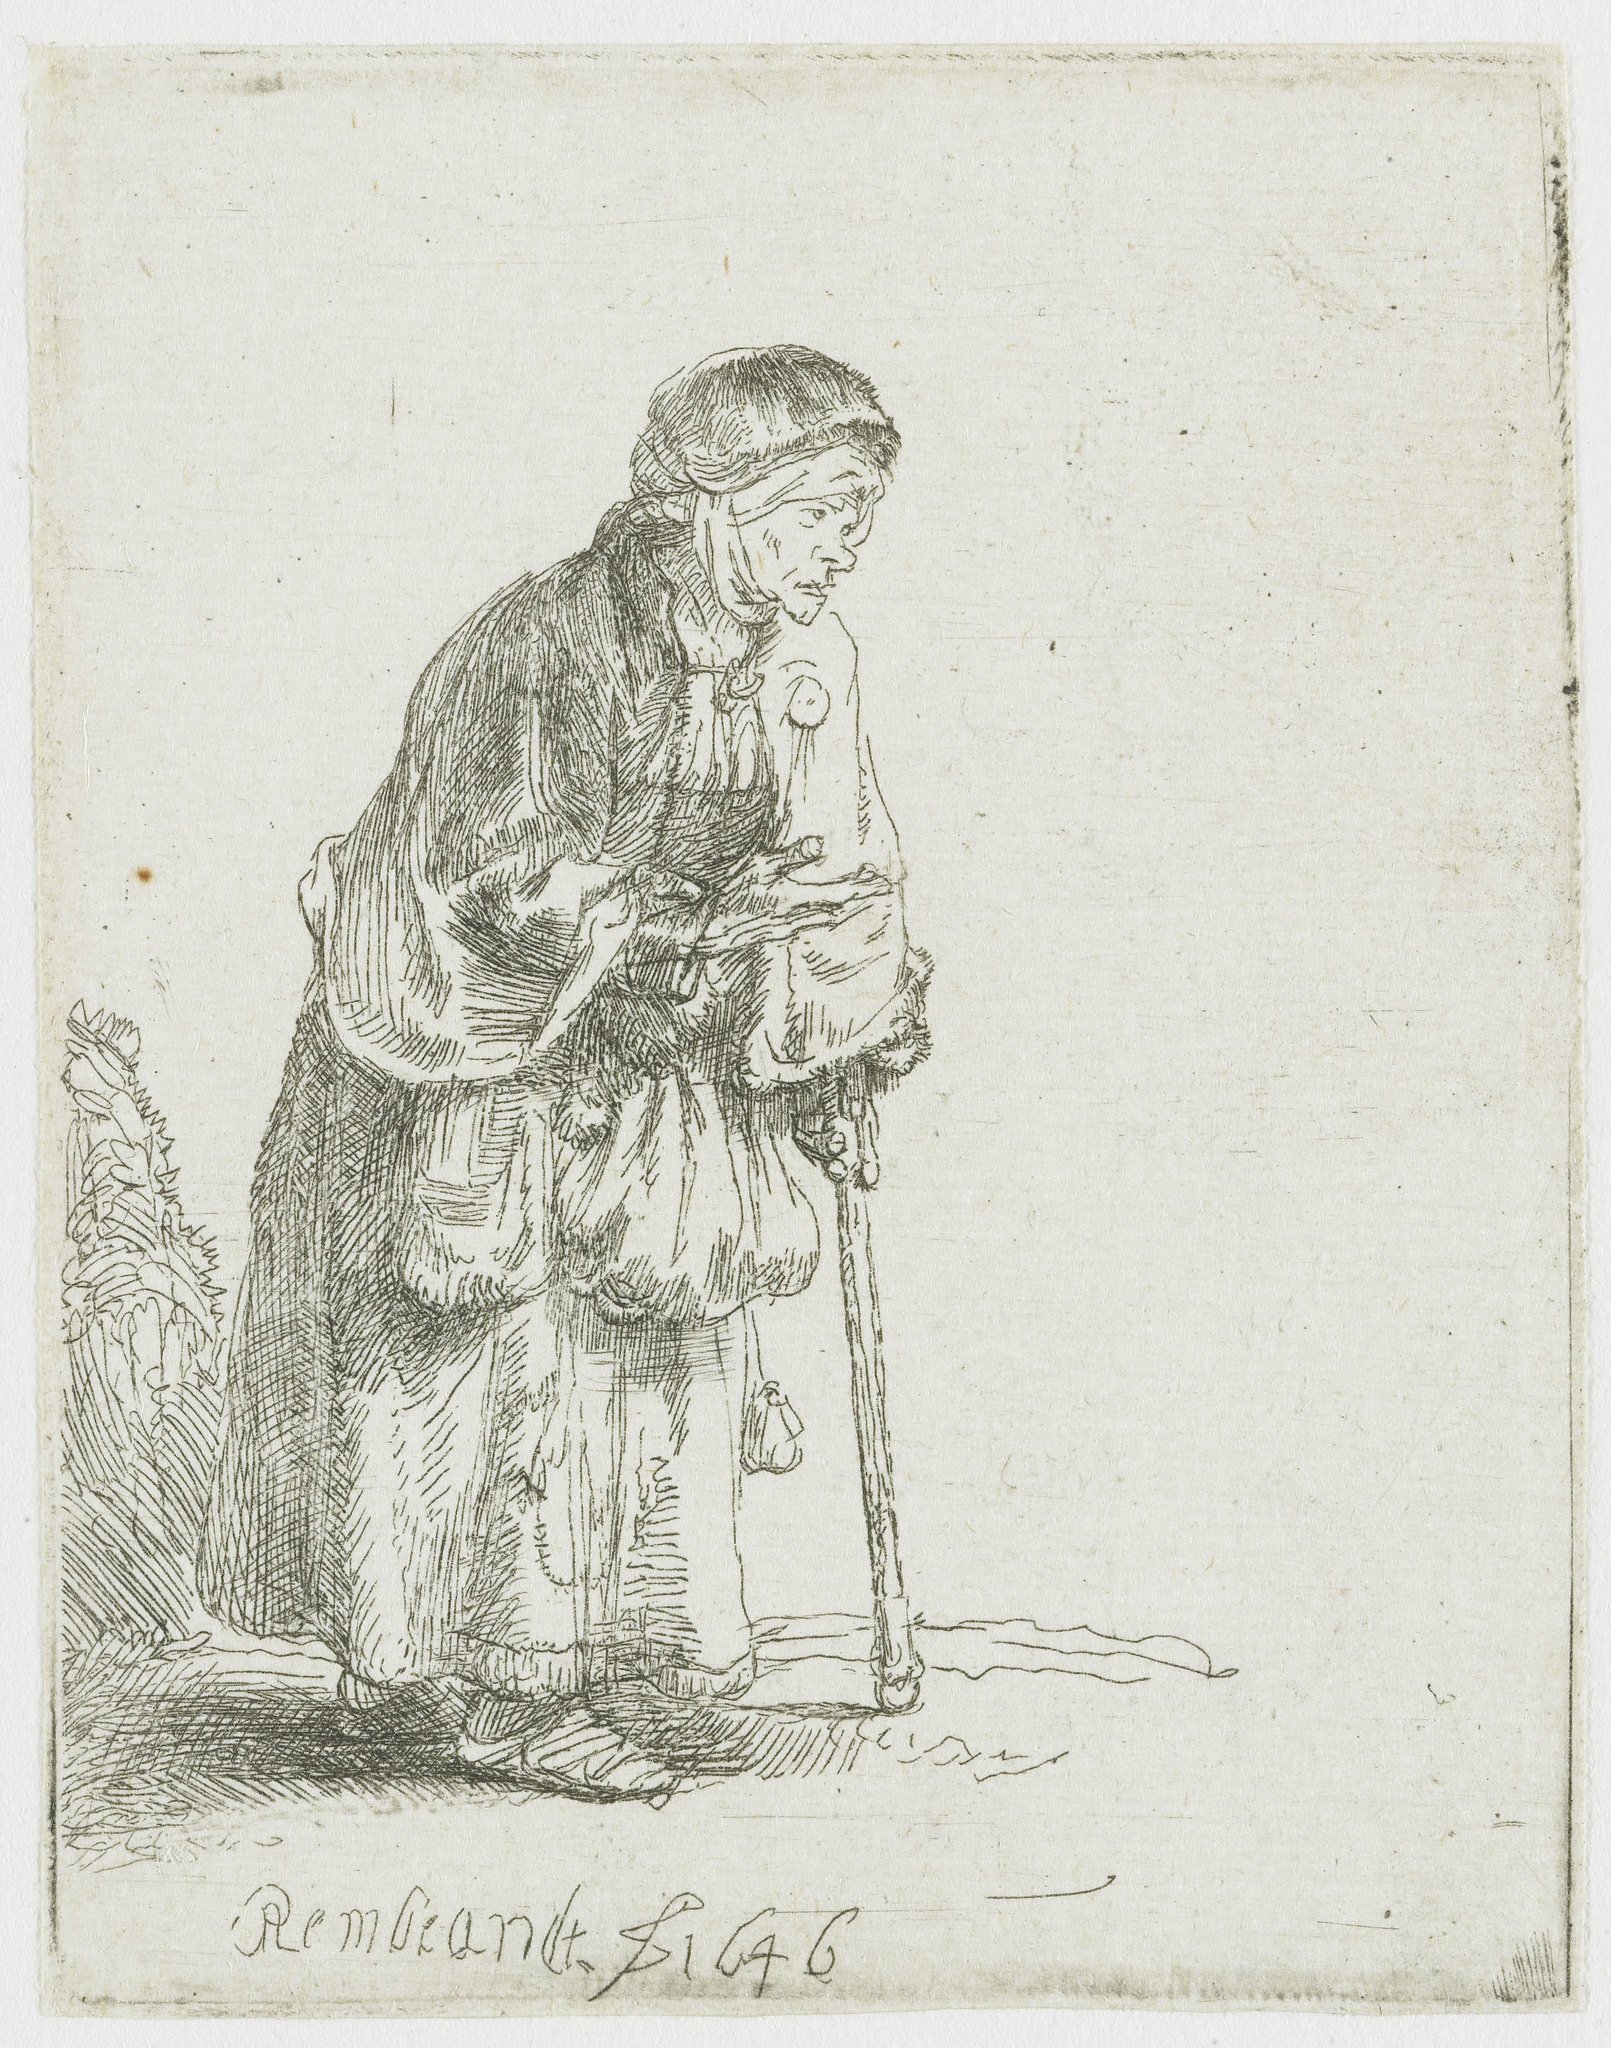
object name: print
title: Beggar woman leaning on a stick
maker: rembrandt van rijn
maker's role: draughtsman, painter, print maker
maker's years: 1606-1669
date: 1646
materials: paper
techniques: drypoint, etching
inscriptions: signature and date: ‘Rembrandt f. 1646’, collector's mark: Lugt 240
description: In his early work, Rembrandt revealed an unending fascination with common people. Later, he revisited this subject only incidentally, as in these two prints, which still attest to his mastery. With a few deft lines, he rendered the toddler at the left, who appears to be walking along with his family only because his father holds his hand firmly.